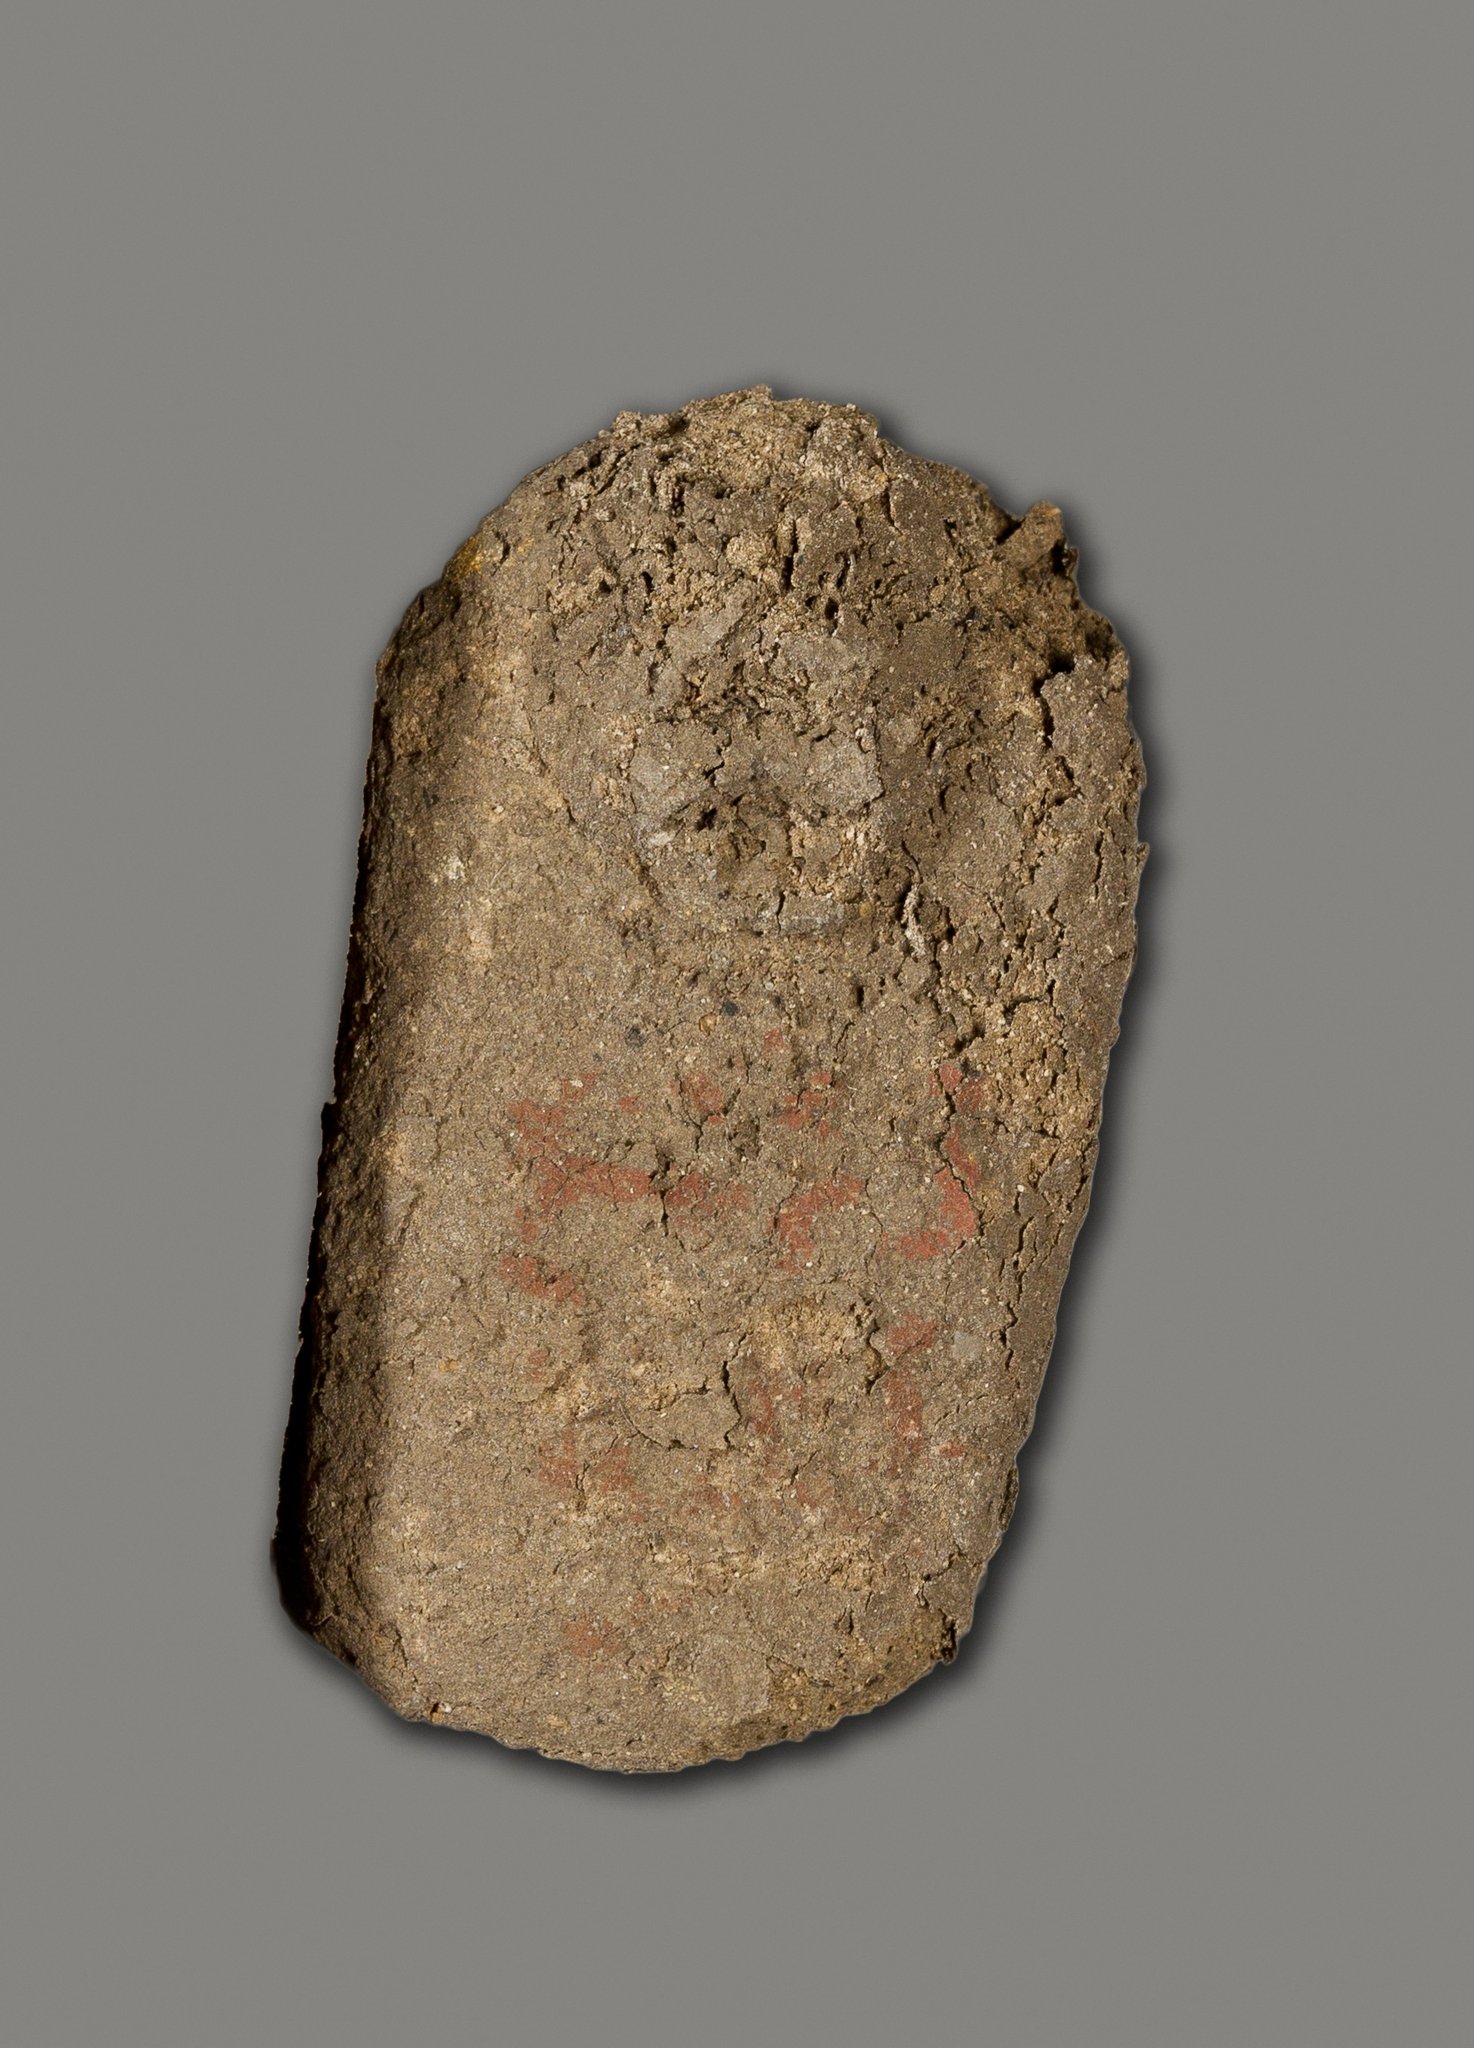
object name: figure, magical, execration, tablet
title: Magical Figure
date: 1802-1550 BCE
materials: clay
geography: egypt